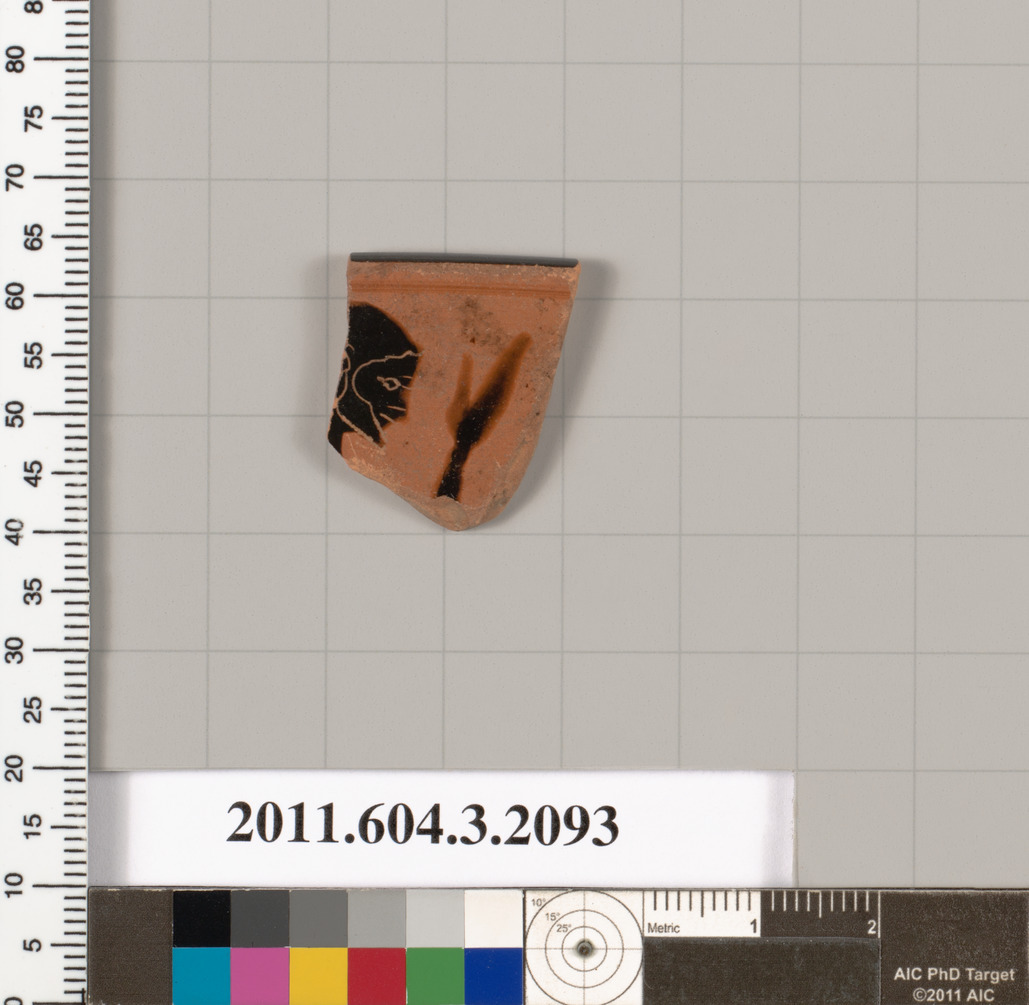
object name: kylix fragment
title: Terracotta rim fragment of a kylix (drinking cup)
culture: greek, attic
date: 534-468 BCE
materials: terracotta